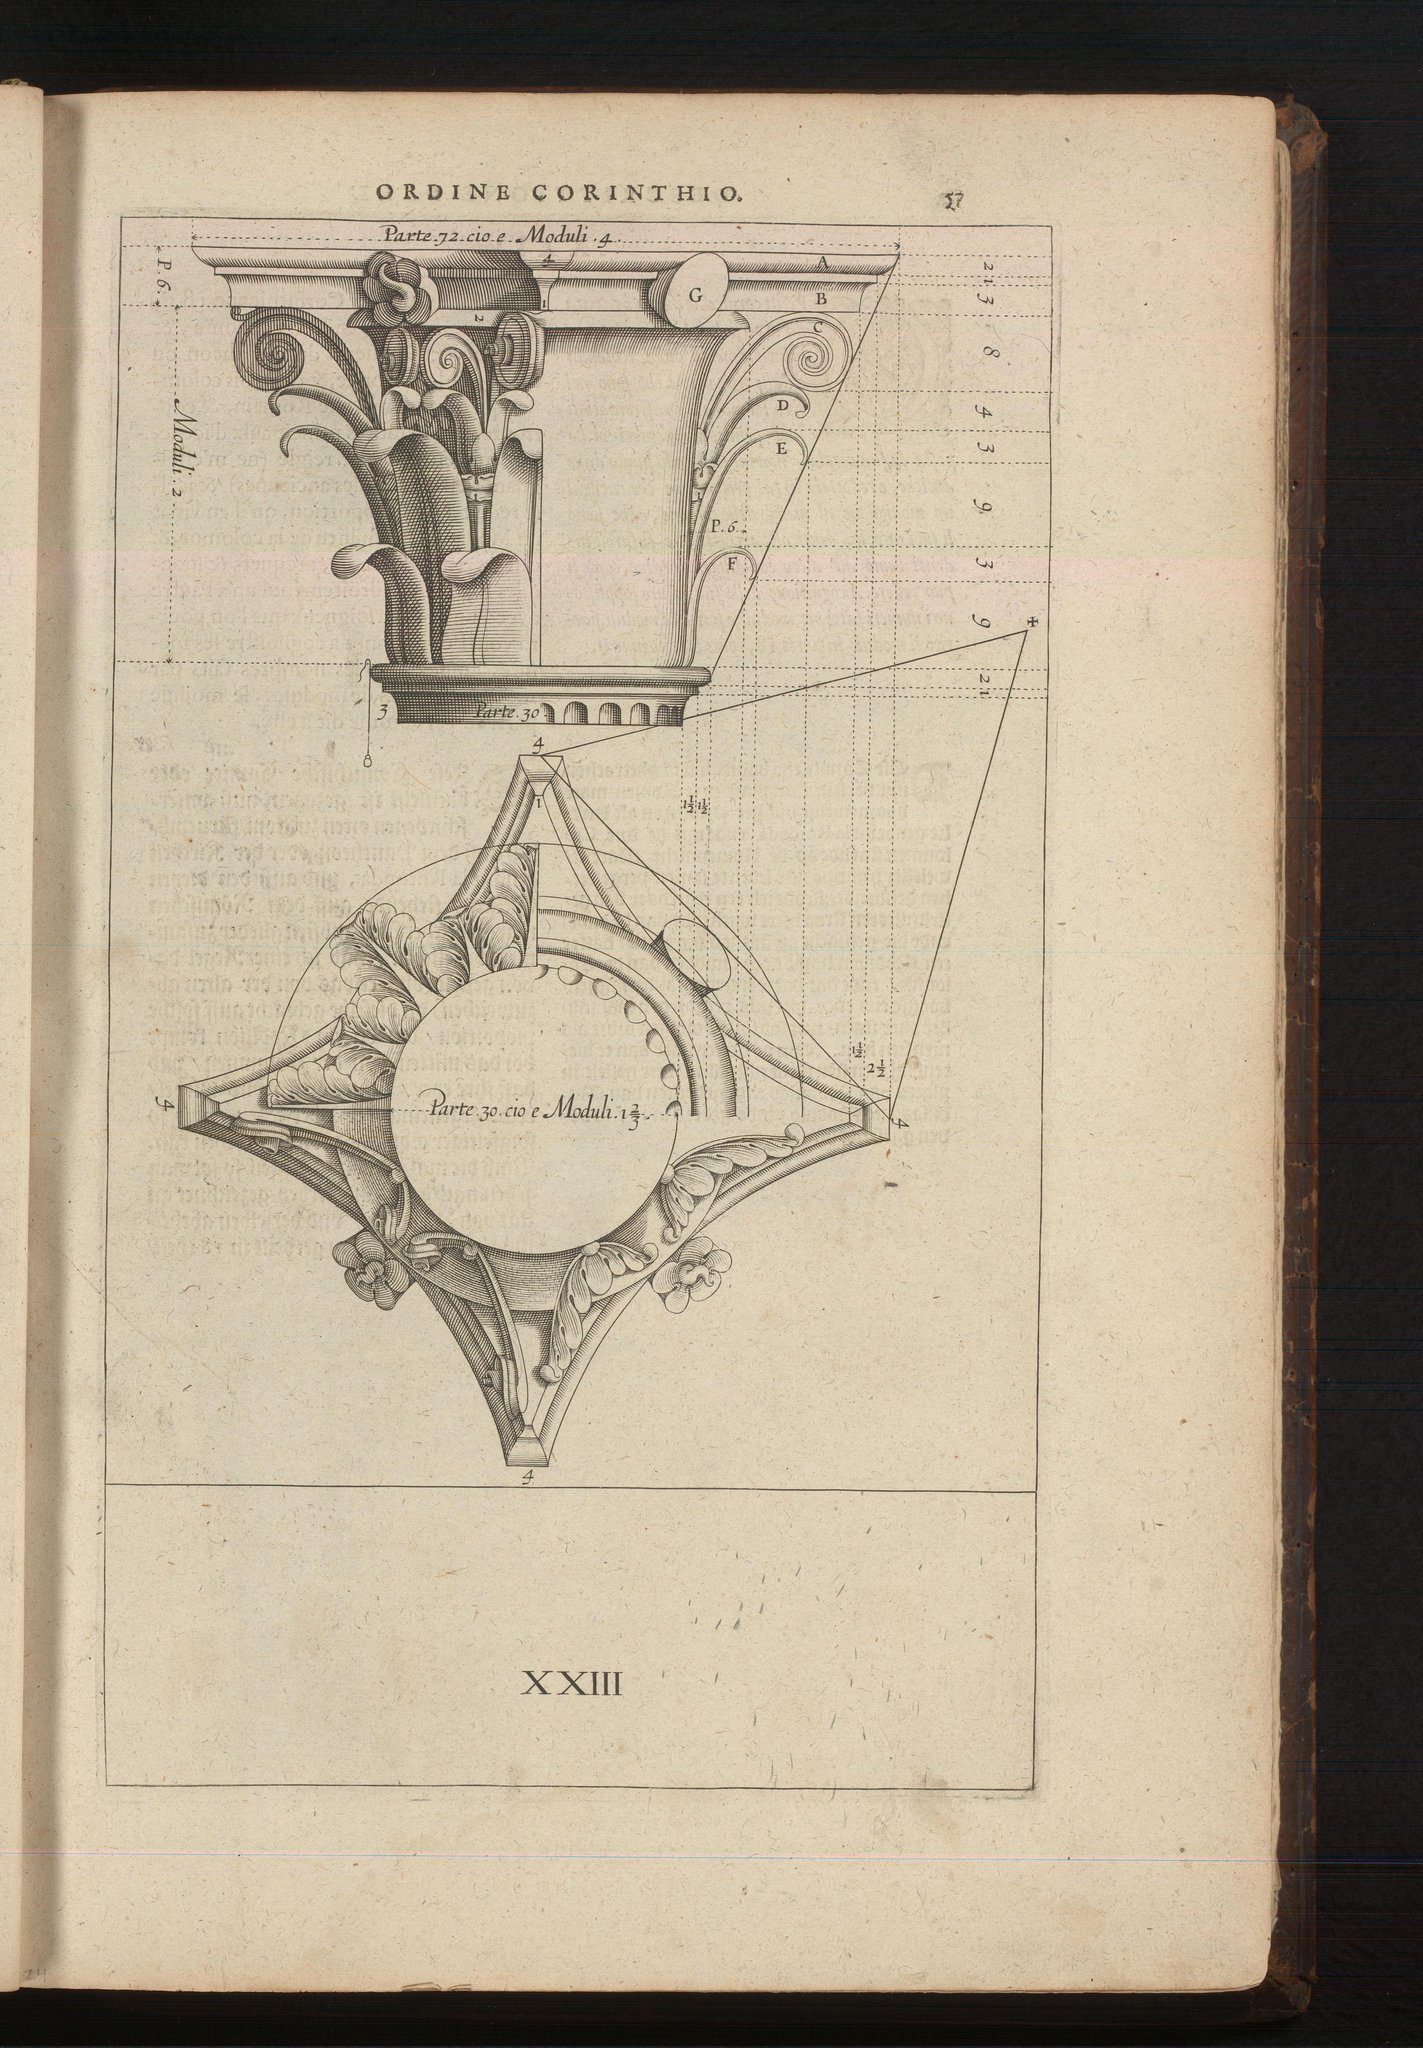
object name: print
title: Korinthisch kapiteel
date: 1640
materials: paper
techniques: engraving, letterpress printing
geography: amsterdam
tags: orders, order-books ~ architecture, corinthian order ~ architecture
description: Prent uit: Vignola, Giacomo Barozzi da. Regola delli cinque ordini d'architettura (...). Amsterdam: Johannes Willemszoon en Cornelis Blaeu, 1640, p. 57.